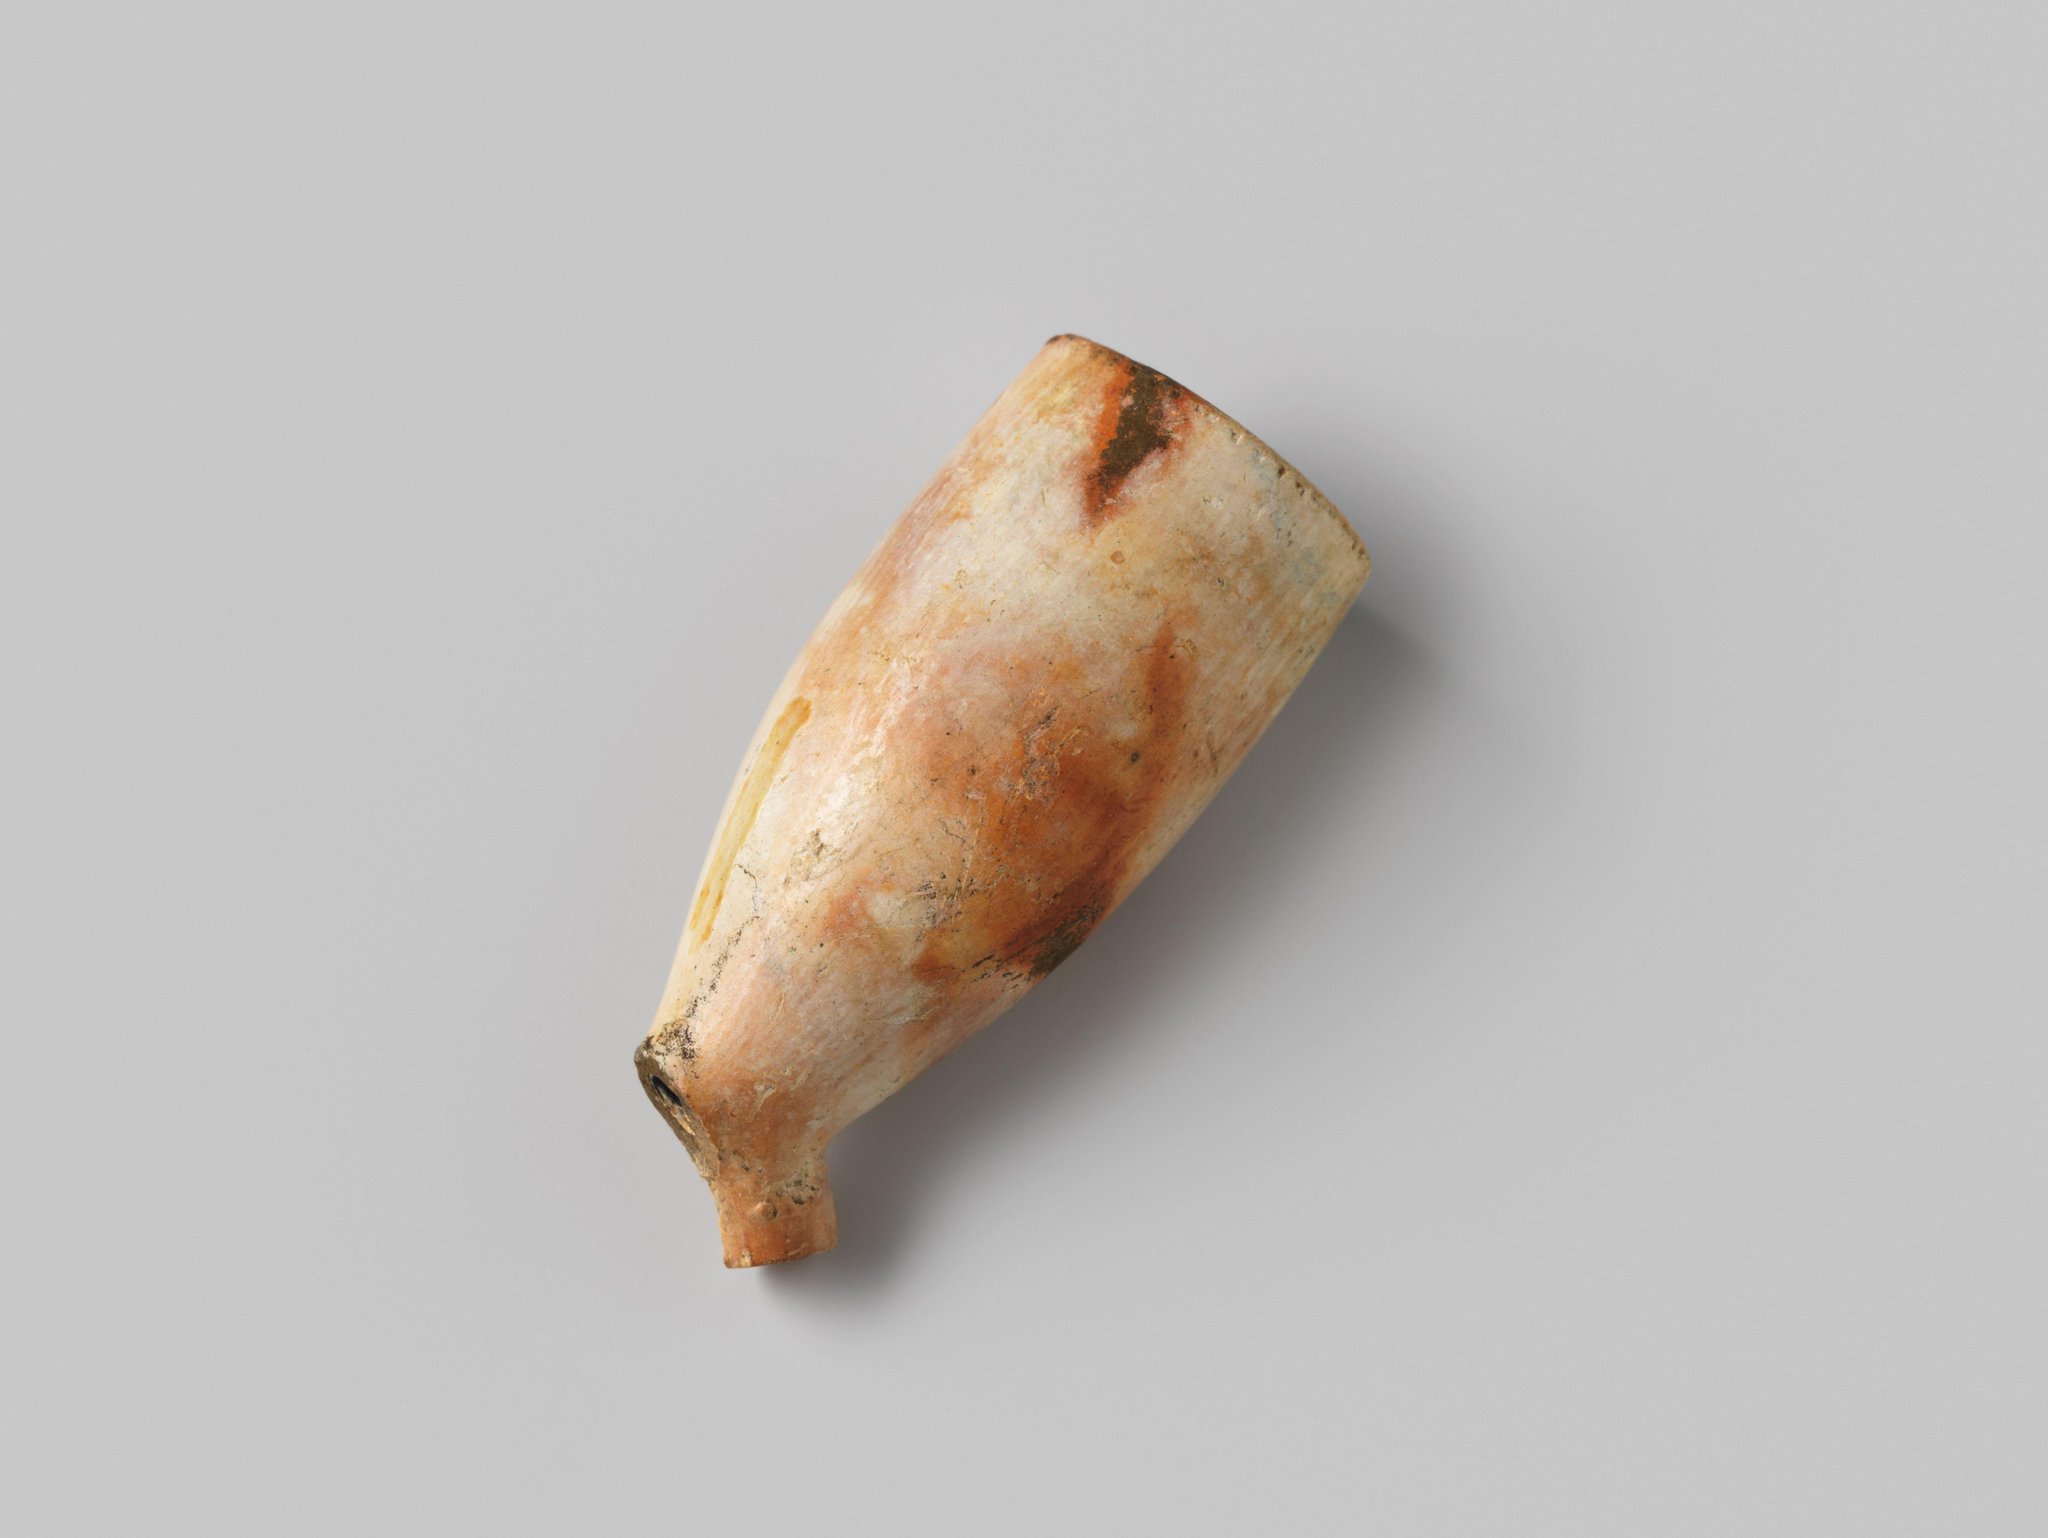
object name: pipe bowl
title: Pijpenkop uit het wrak van de Oost-Indiëvaarder Hollandia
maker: Anonymous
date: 1700-1743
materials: clay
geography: netherlands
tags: verenigde oostindische compagnie, hollandia (schip), annet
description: Pipe, bowl, heelmark: fish, flounder; fragm, 2hsm1,6.